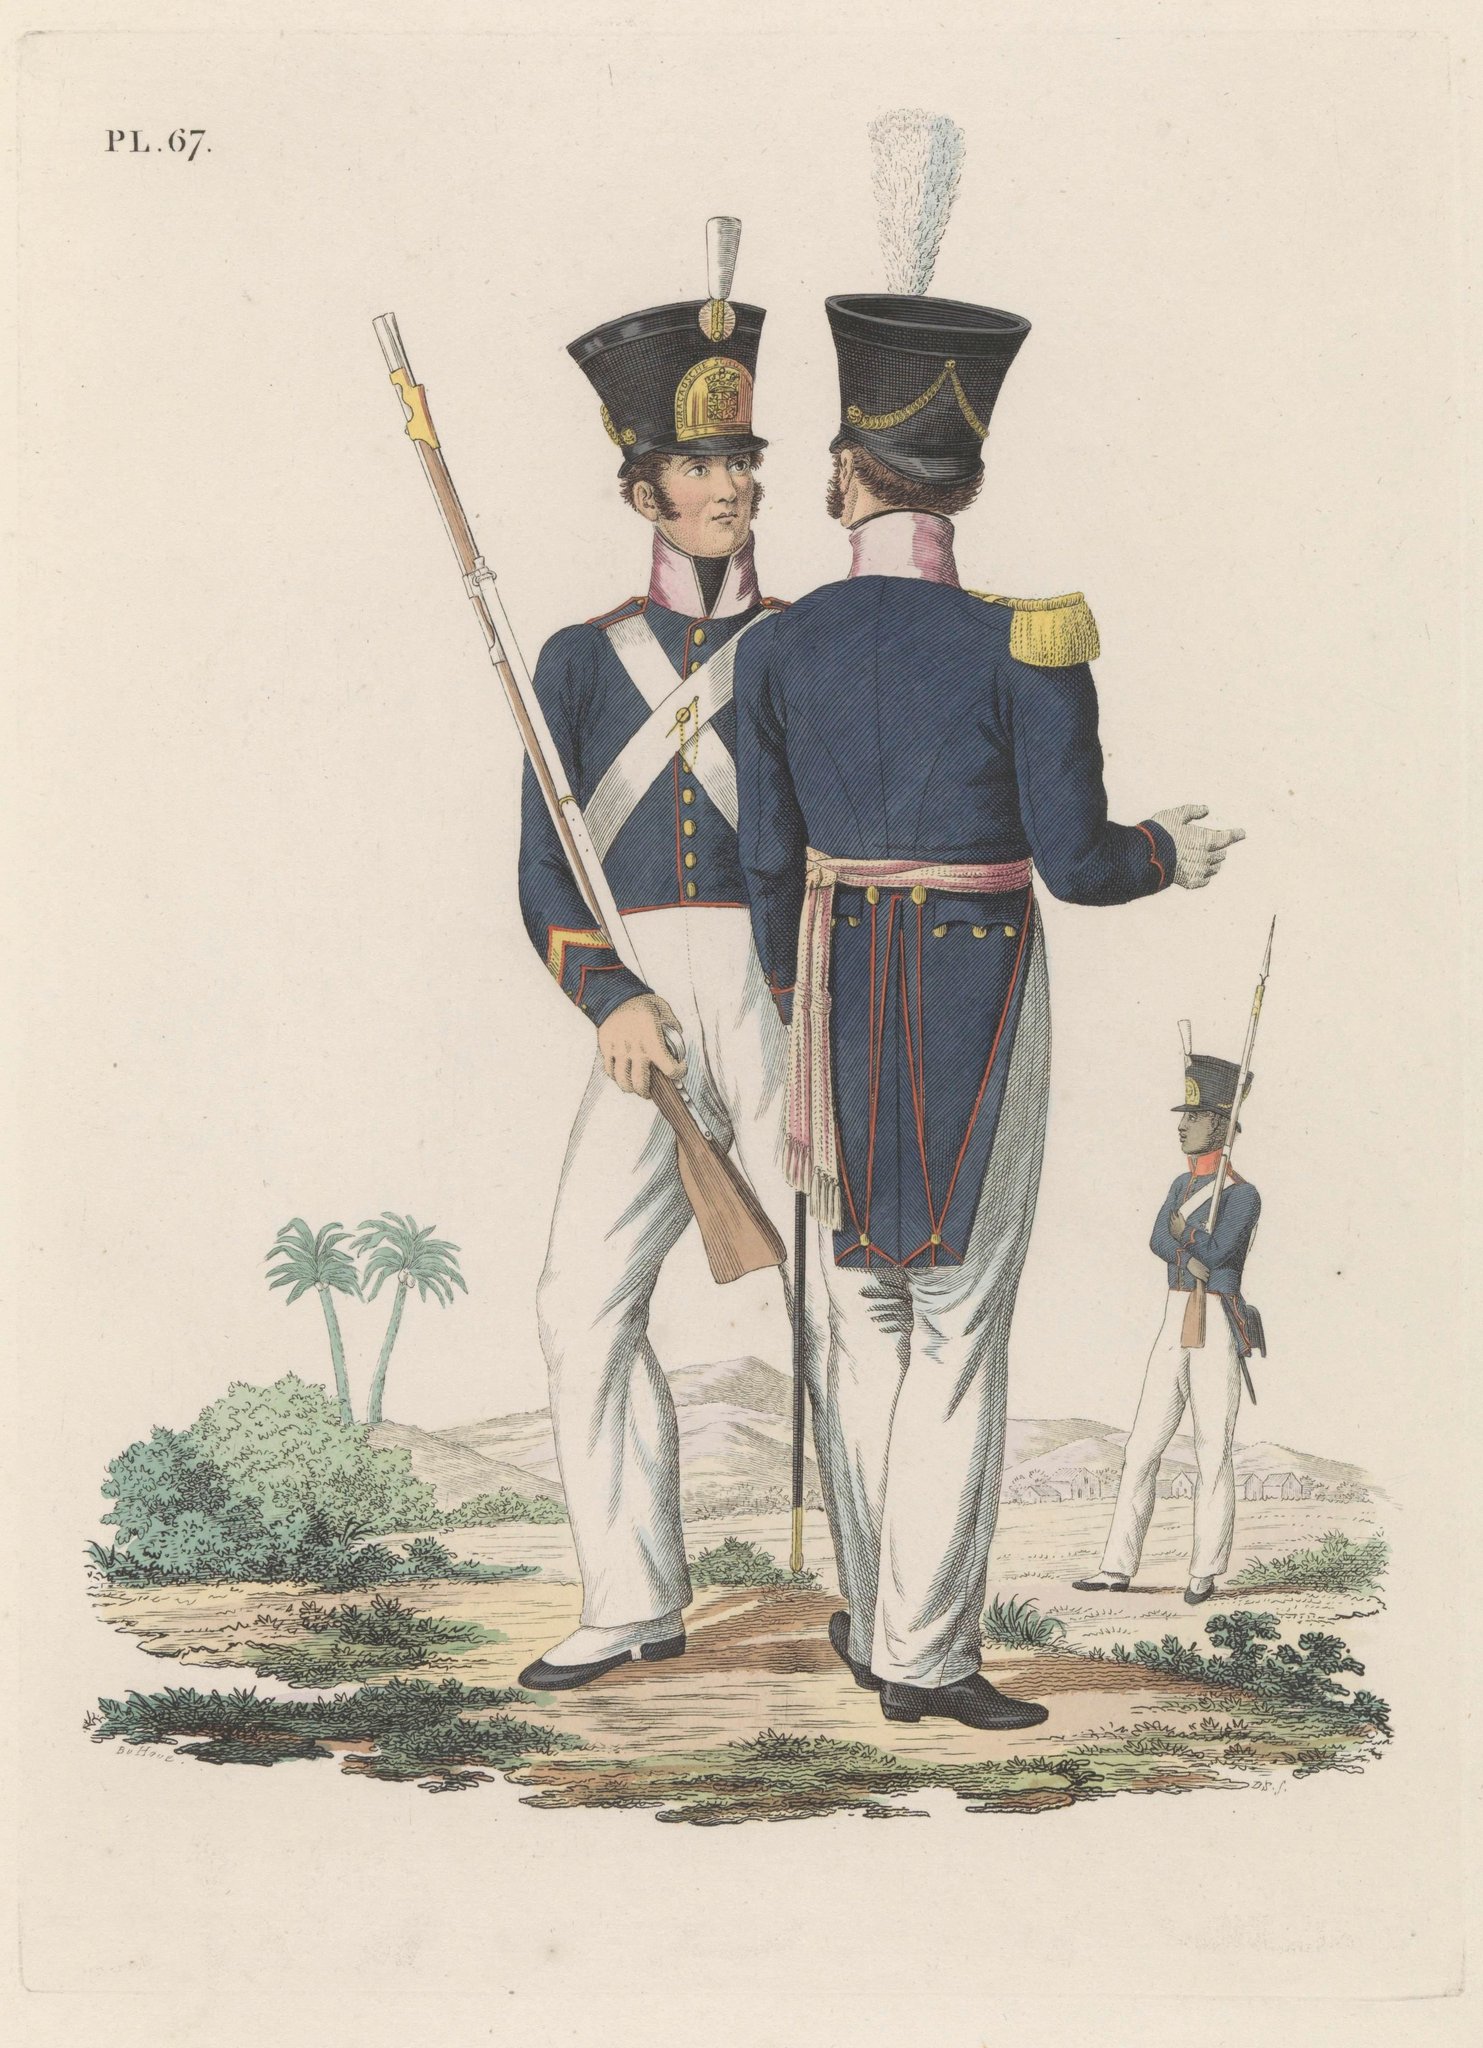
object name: print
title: Curaçaaosche Schutterij; Officier, Onder-Officier en Schutter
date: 1826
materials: paper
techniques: engraving, etching, hand coloring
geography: the hague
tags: (military) uniforms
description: Nederlandse officier, onderofficier en schutter van de Curaçaosche Schutterij. Plaat 67. Uniformvoorstelling in 'Vervolg van de Beschrijving hoedanig de Koninklijke Nederlandsche troepen' van J.F. Teupken, 1826.